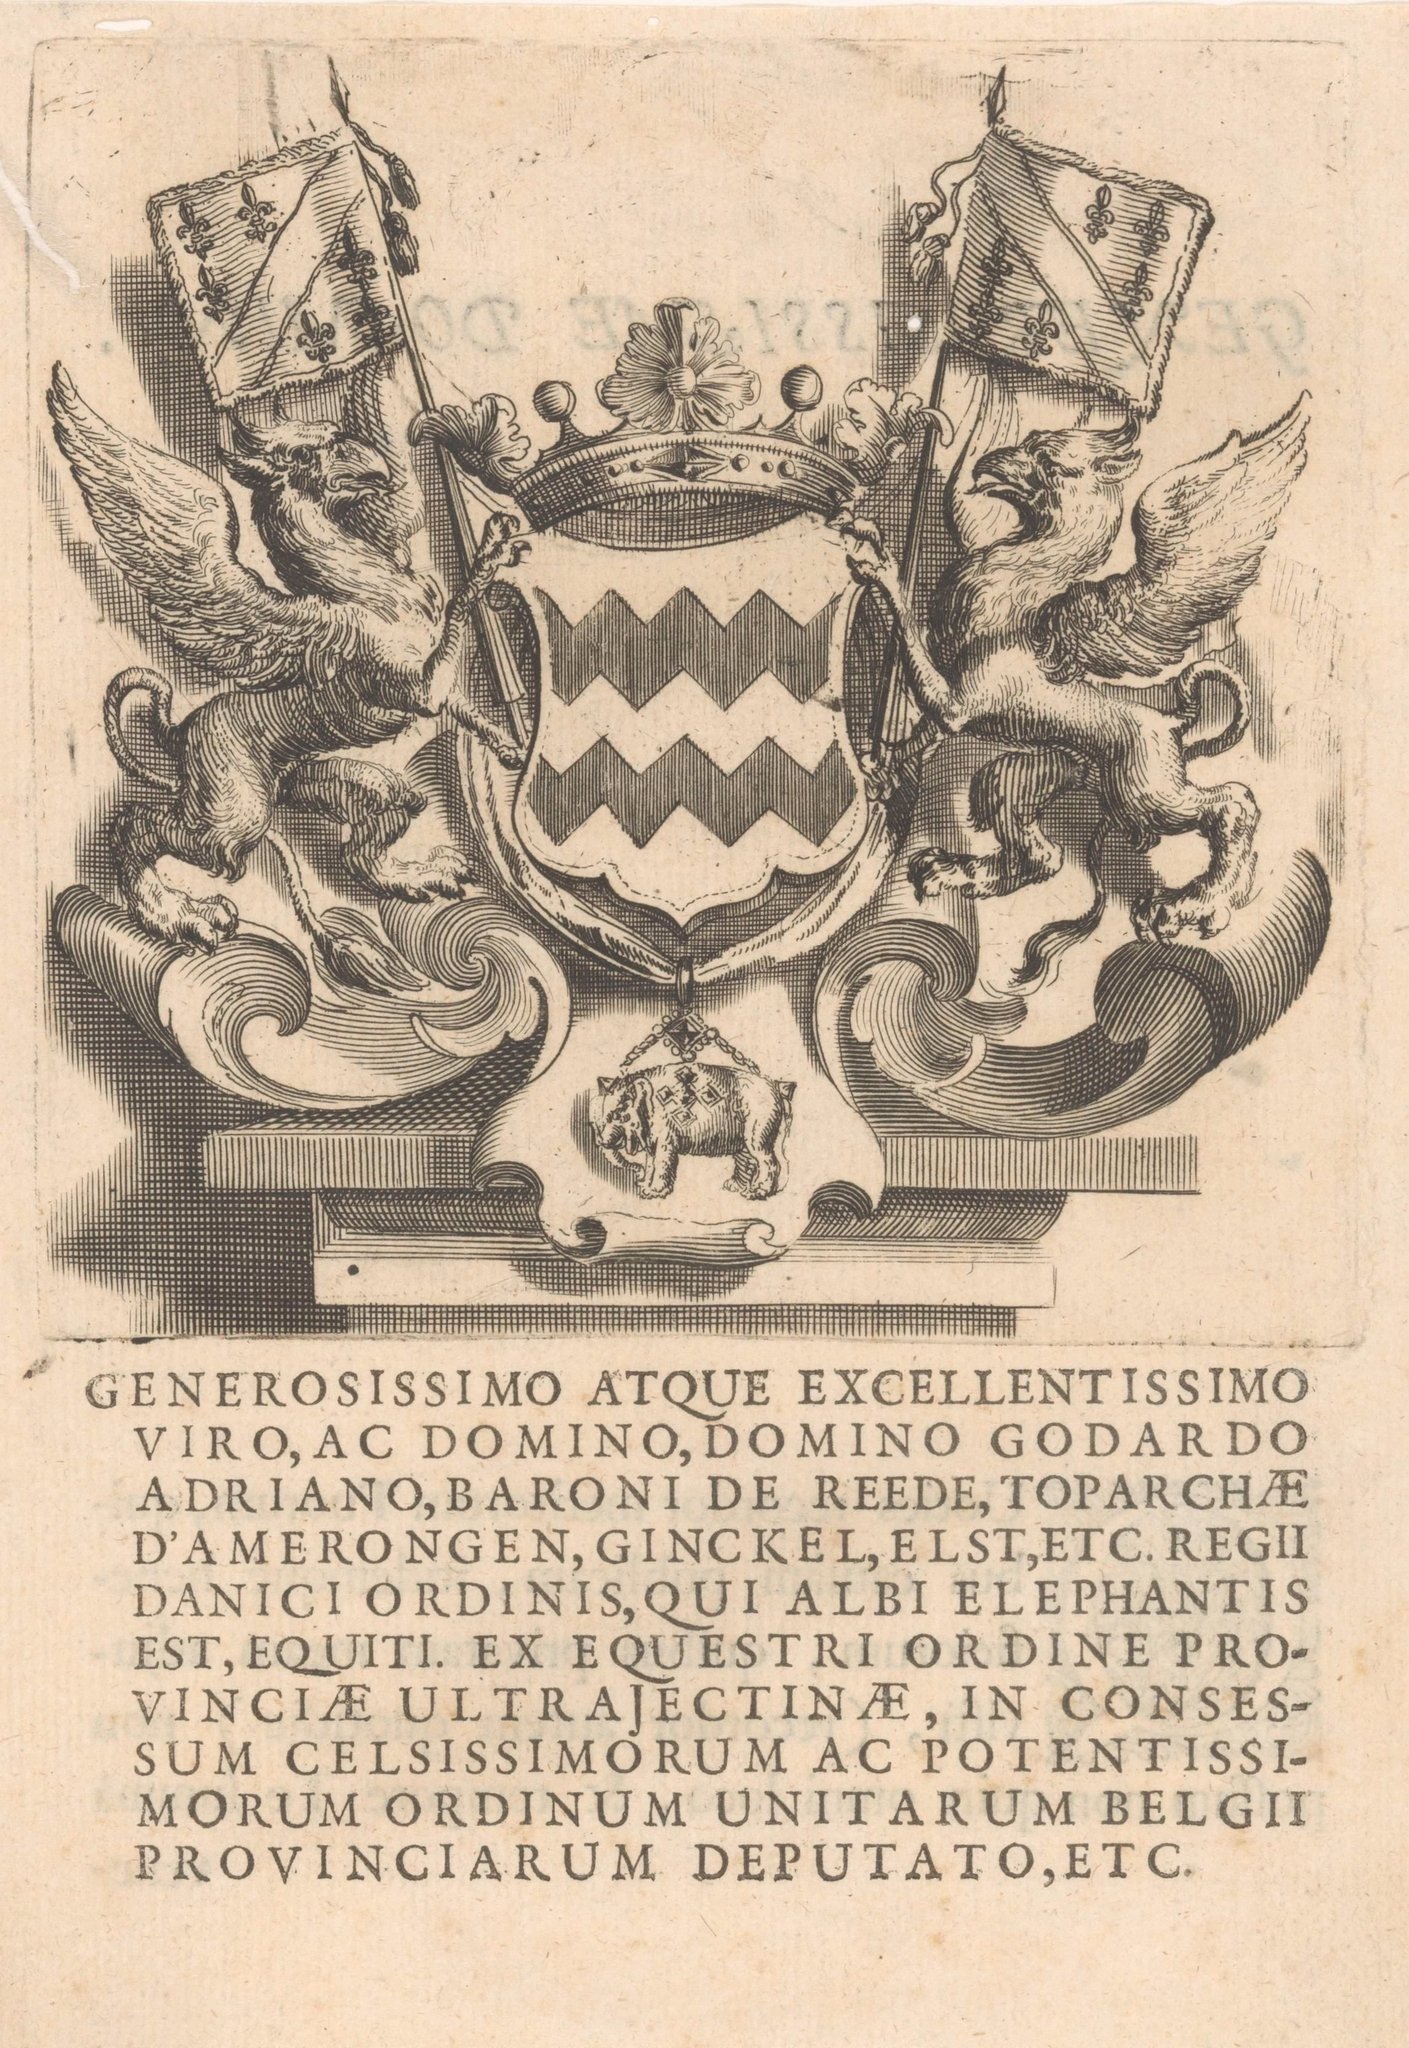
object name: book illustration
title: Wapenschild van Godard Adriaan van Reede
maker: Anonymous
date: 1660-1700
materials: paper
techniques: etching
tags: armorial bearing, heraldry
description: Wapenschild van Godard Adriaan van Reede met griffioenen als schildhouders en het ordeteken van de Witte Olifant. Aan de onderzijde een tienregelige Latijnse tekst.